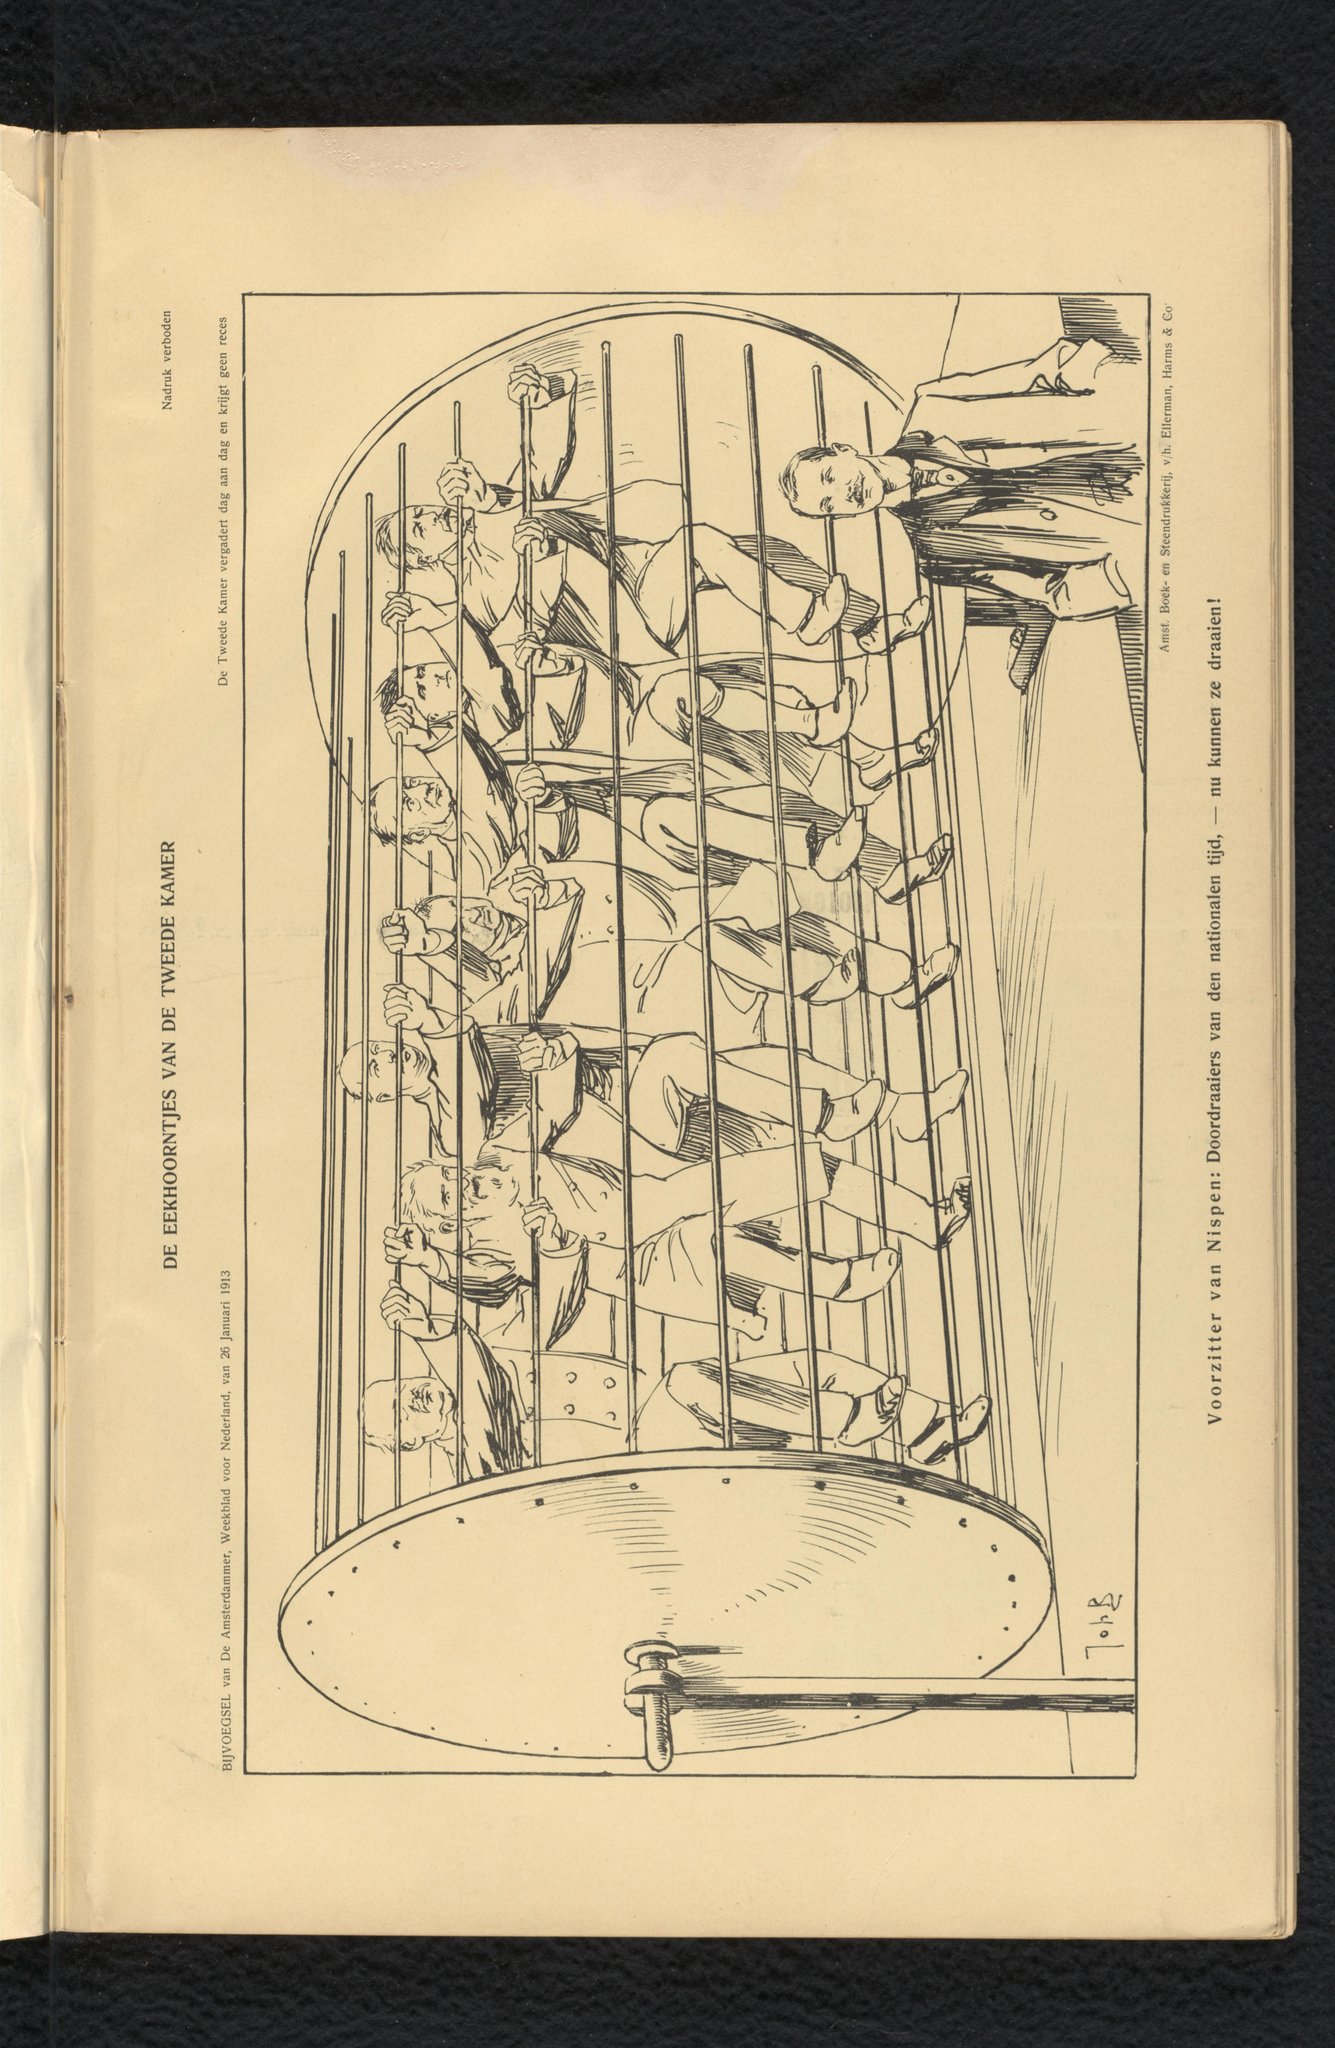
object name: cartoon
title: De eekhoorntjes van de Tweede Kamer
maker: johan braakensiek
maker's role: draughtsman, print maker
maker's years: 1858-1940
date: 1913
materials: paper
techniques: lithograph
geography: amsterdam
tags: politician, debate, discussion (~ parliament), political caricatures and satires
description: Tweede Kamerleden die als eekhoorns (of hamsters) fanatiek het rad draaiend houden. Rechtsvoor Kamervoorzitter Van Nispen tot Sevenaer.